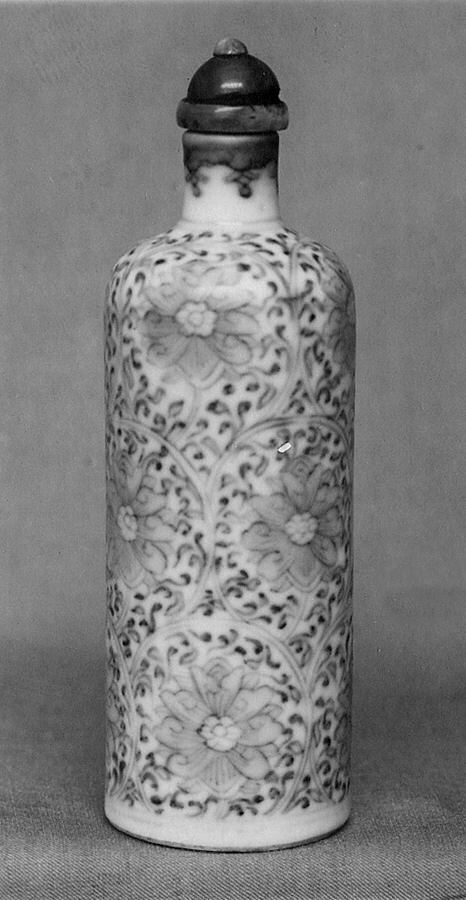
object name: snuff bottle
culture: chinese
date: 1801-1900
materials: porcelain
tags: flowers